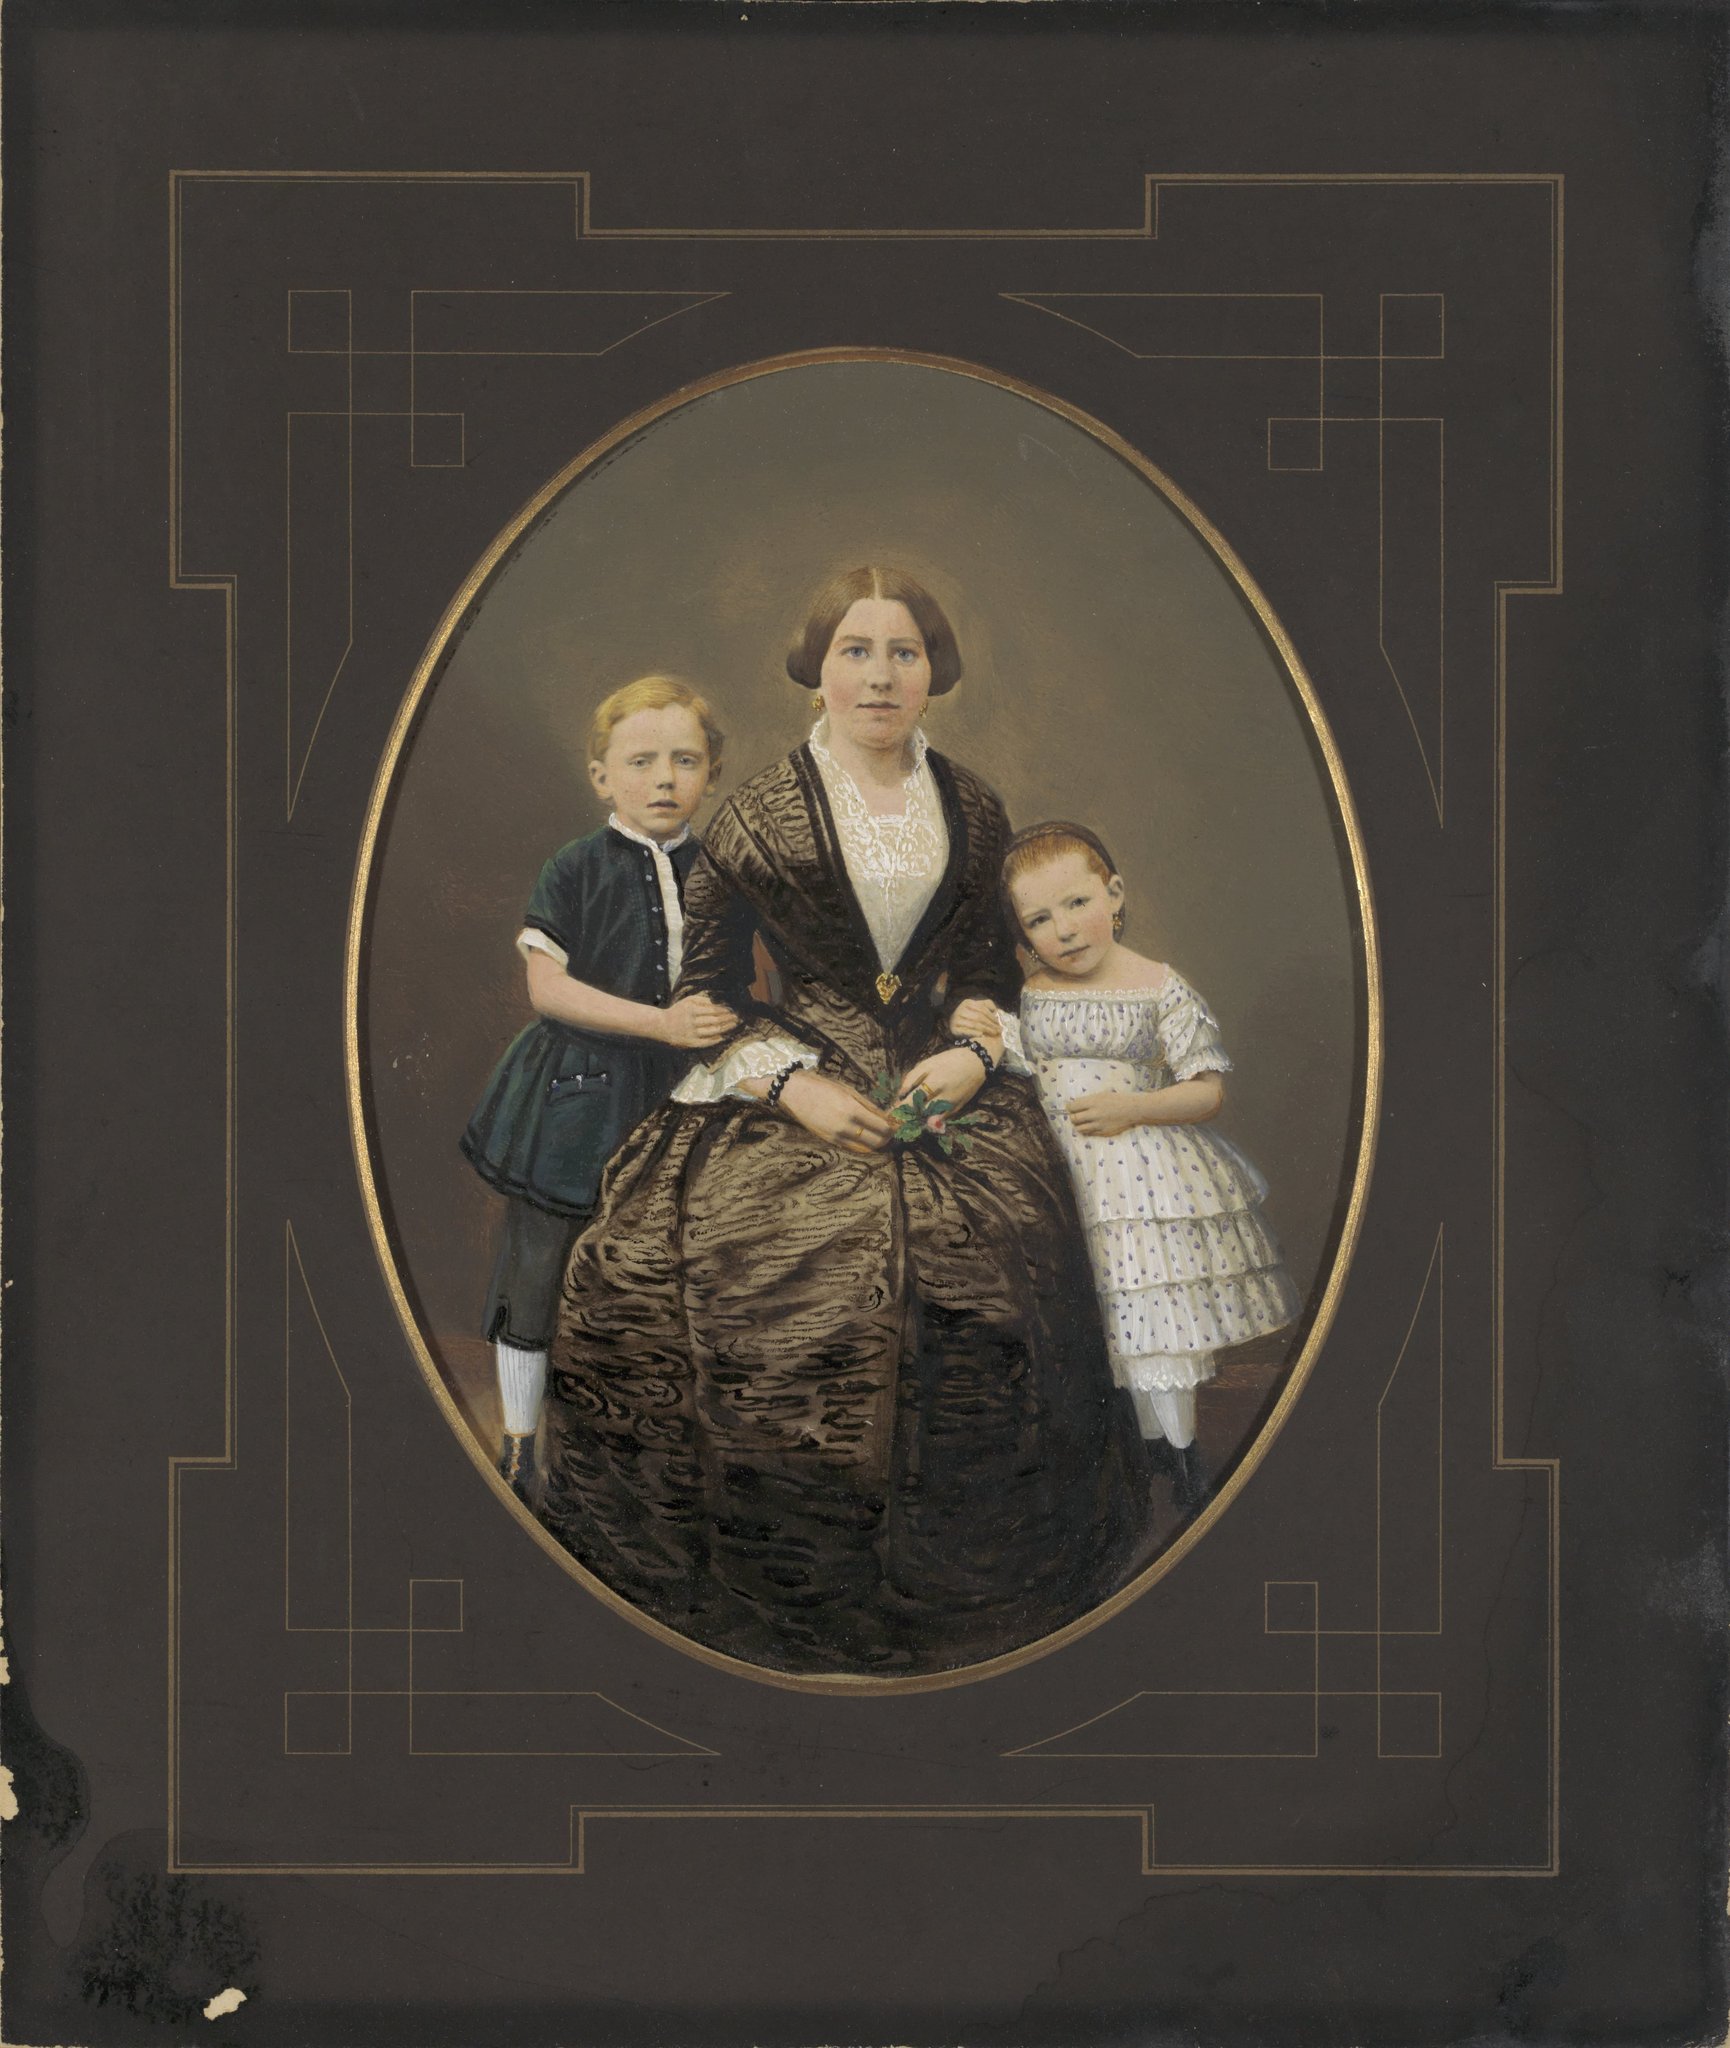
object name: photograph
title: Portret van een moeder met twee kinderen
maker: Anonymous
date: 1880-1920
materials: cardboard, paint, paper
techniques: hand coloring, photography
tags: mother and child(ren), woman and child(ren) (family group)